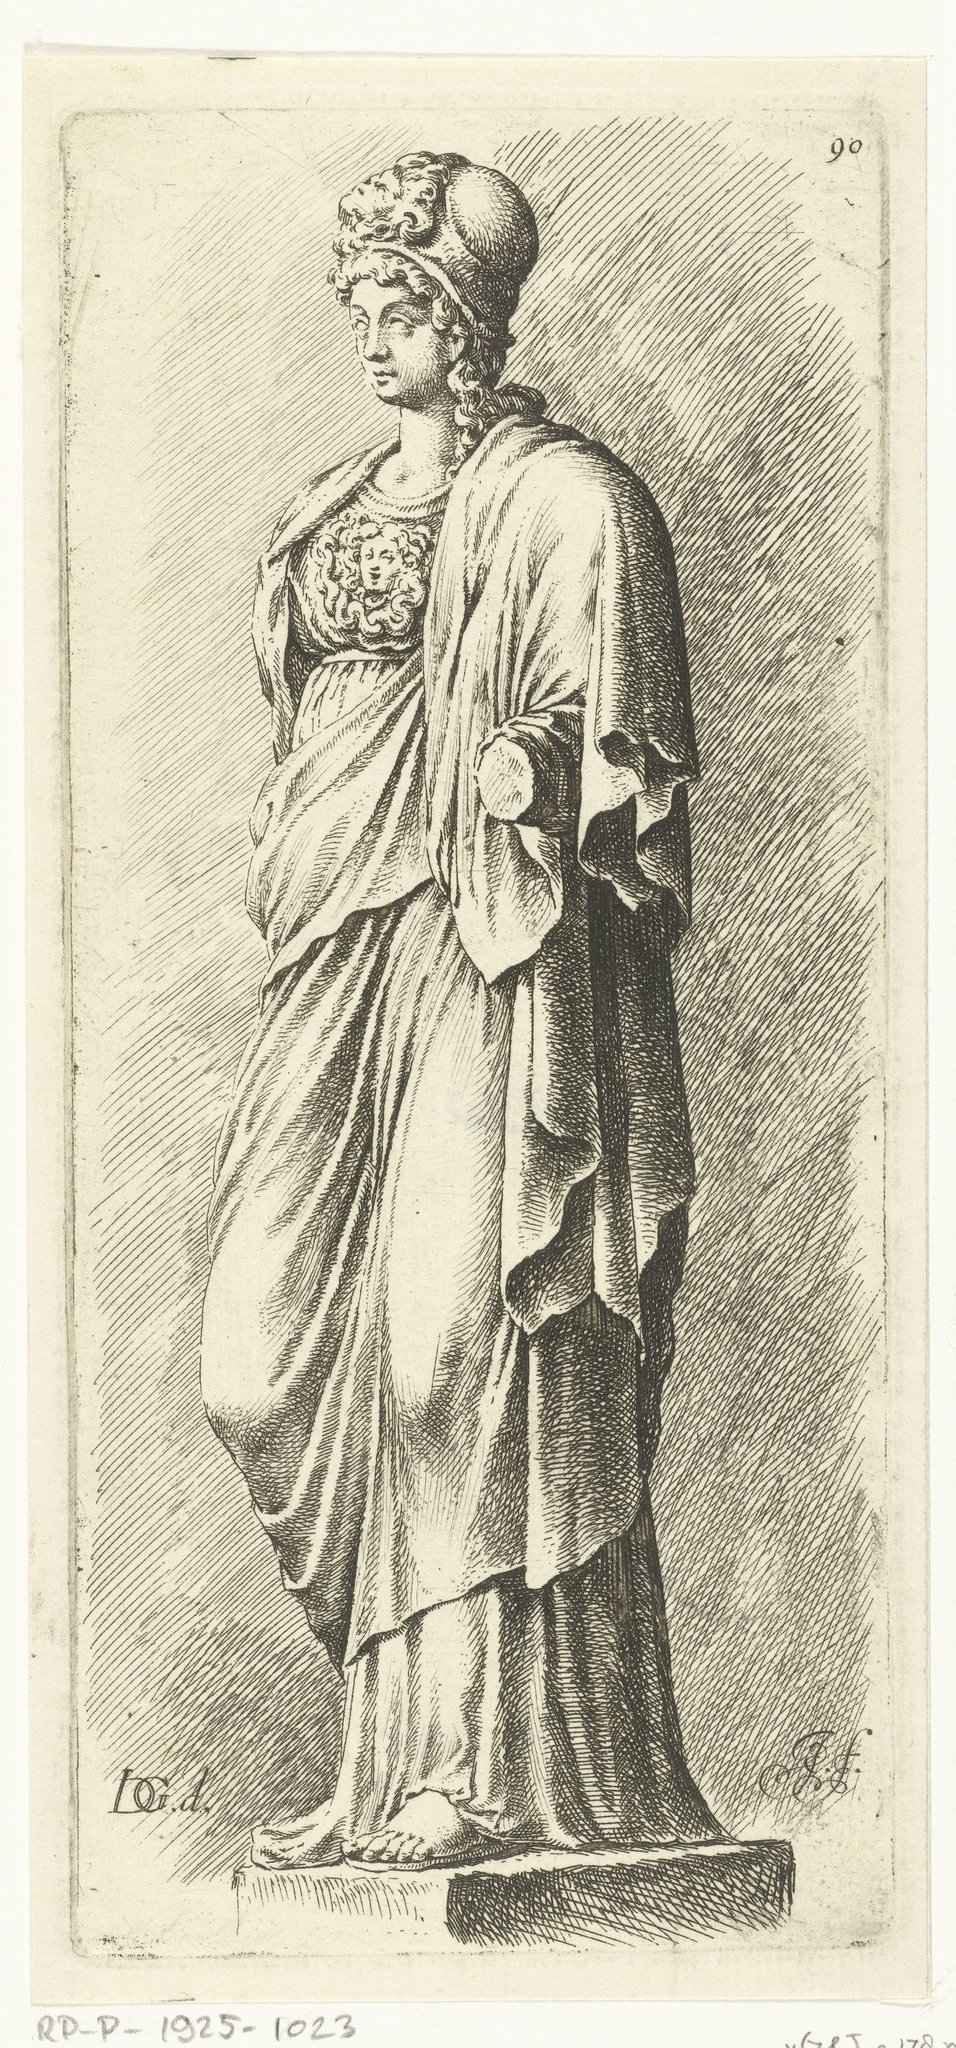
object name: print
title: Signorum Veterum Icones II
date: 1664-1669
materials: paper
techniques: etching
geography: northern netherlands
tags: (story of) minerva (pallas, athena)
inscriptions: collector's mark: Lugt 2228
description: afkomstig uit: Jan de Bisschop, Signorum Veterum Icones, deel 2, [c. 1669]